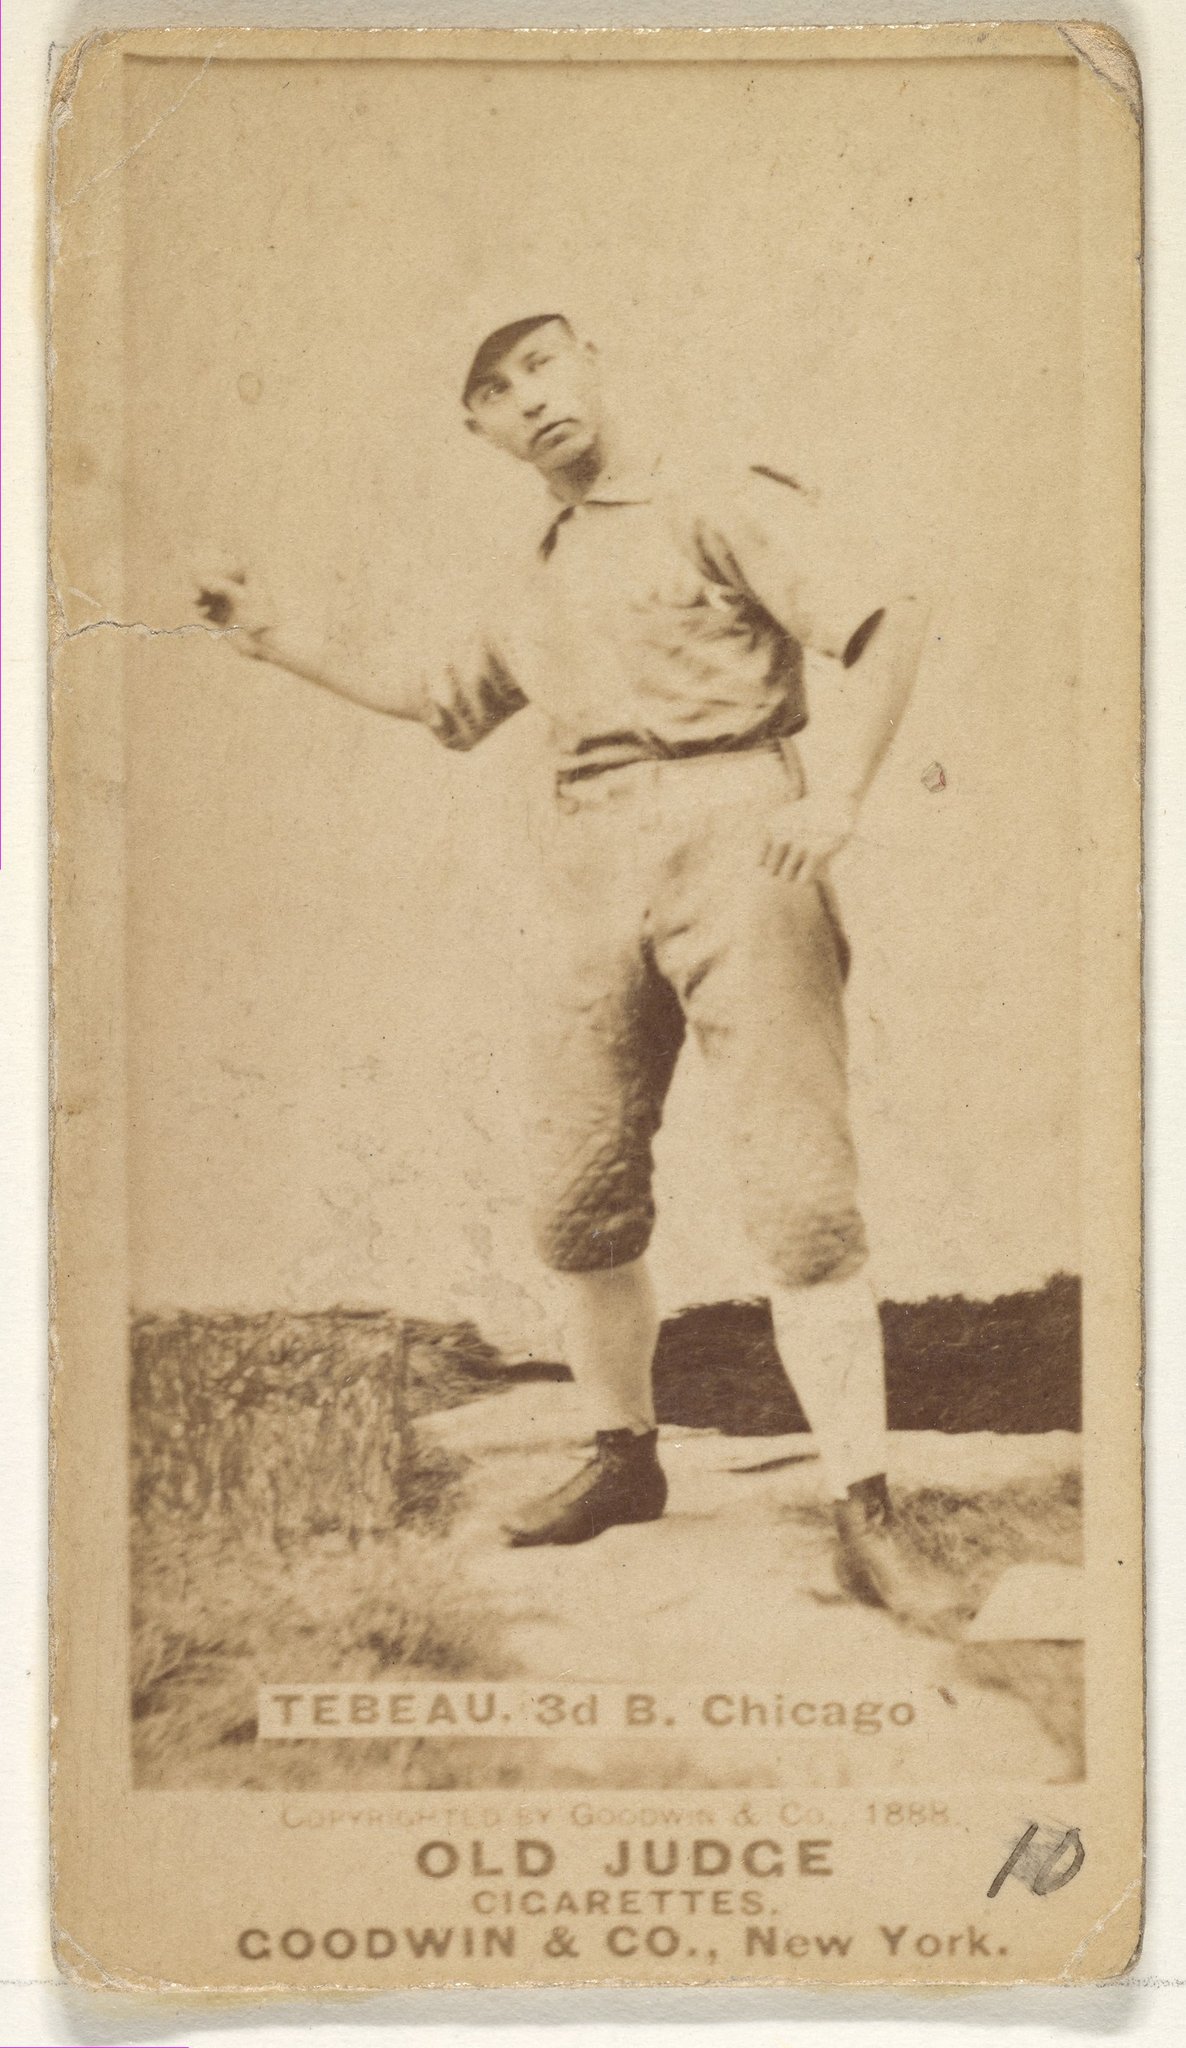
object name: baseball card, photograph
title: Oliver Wendell "Patsy" Tebeau, 3rd Base, Chicago, from the Old Judge series (N172) for Old Judge Cigarettes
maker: goodwin & company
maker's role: publisher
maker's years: 1850-1950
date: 1888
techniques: albumen silver print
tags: men,portraits,baseball,athletes